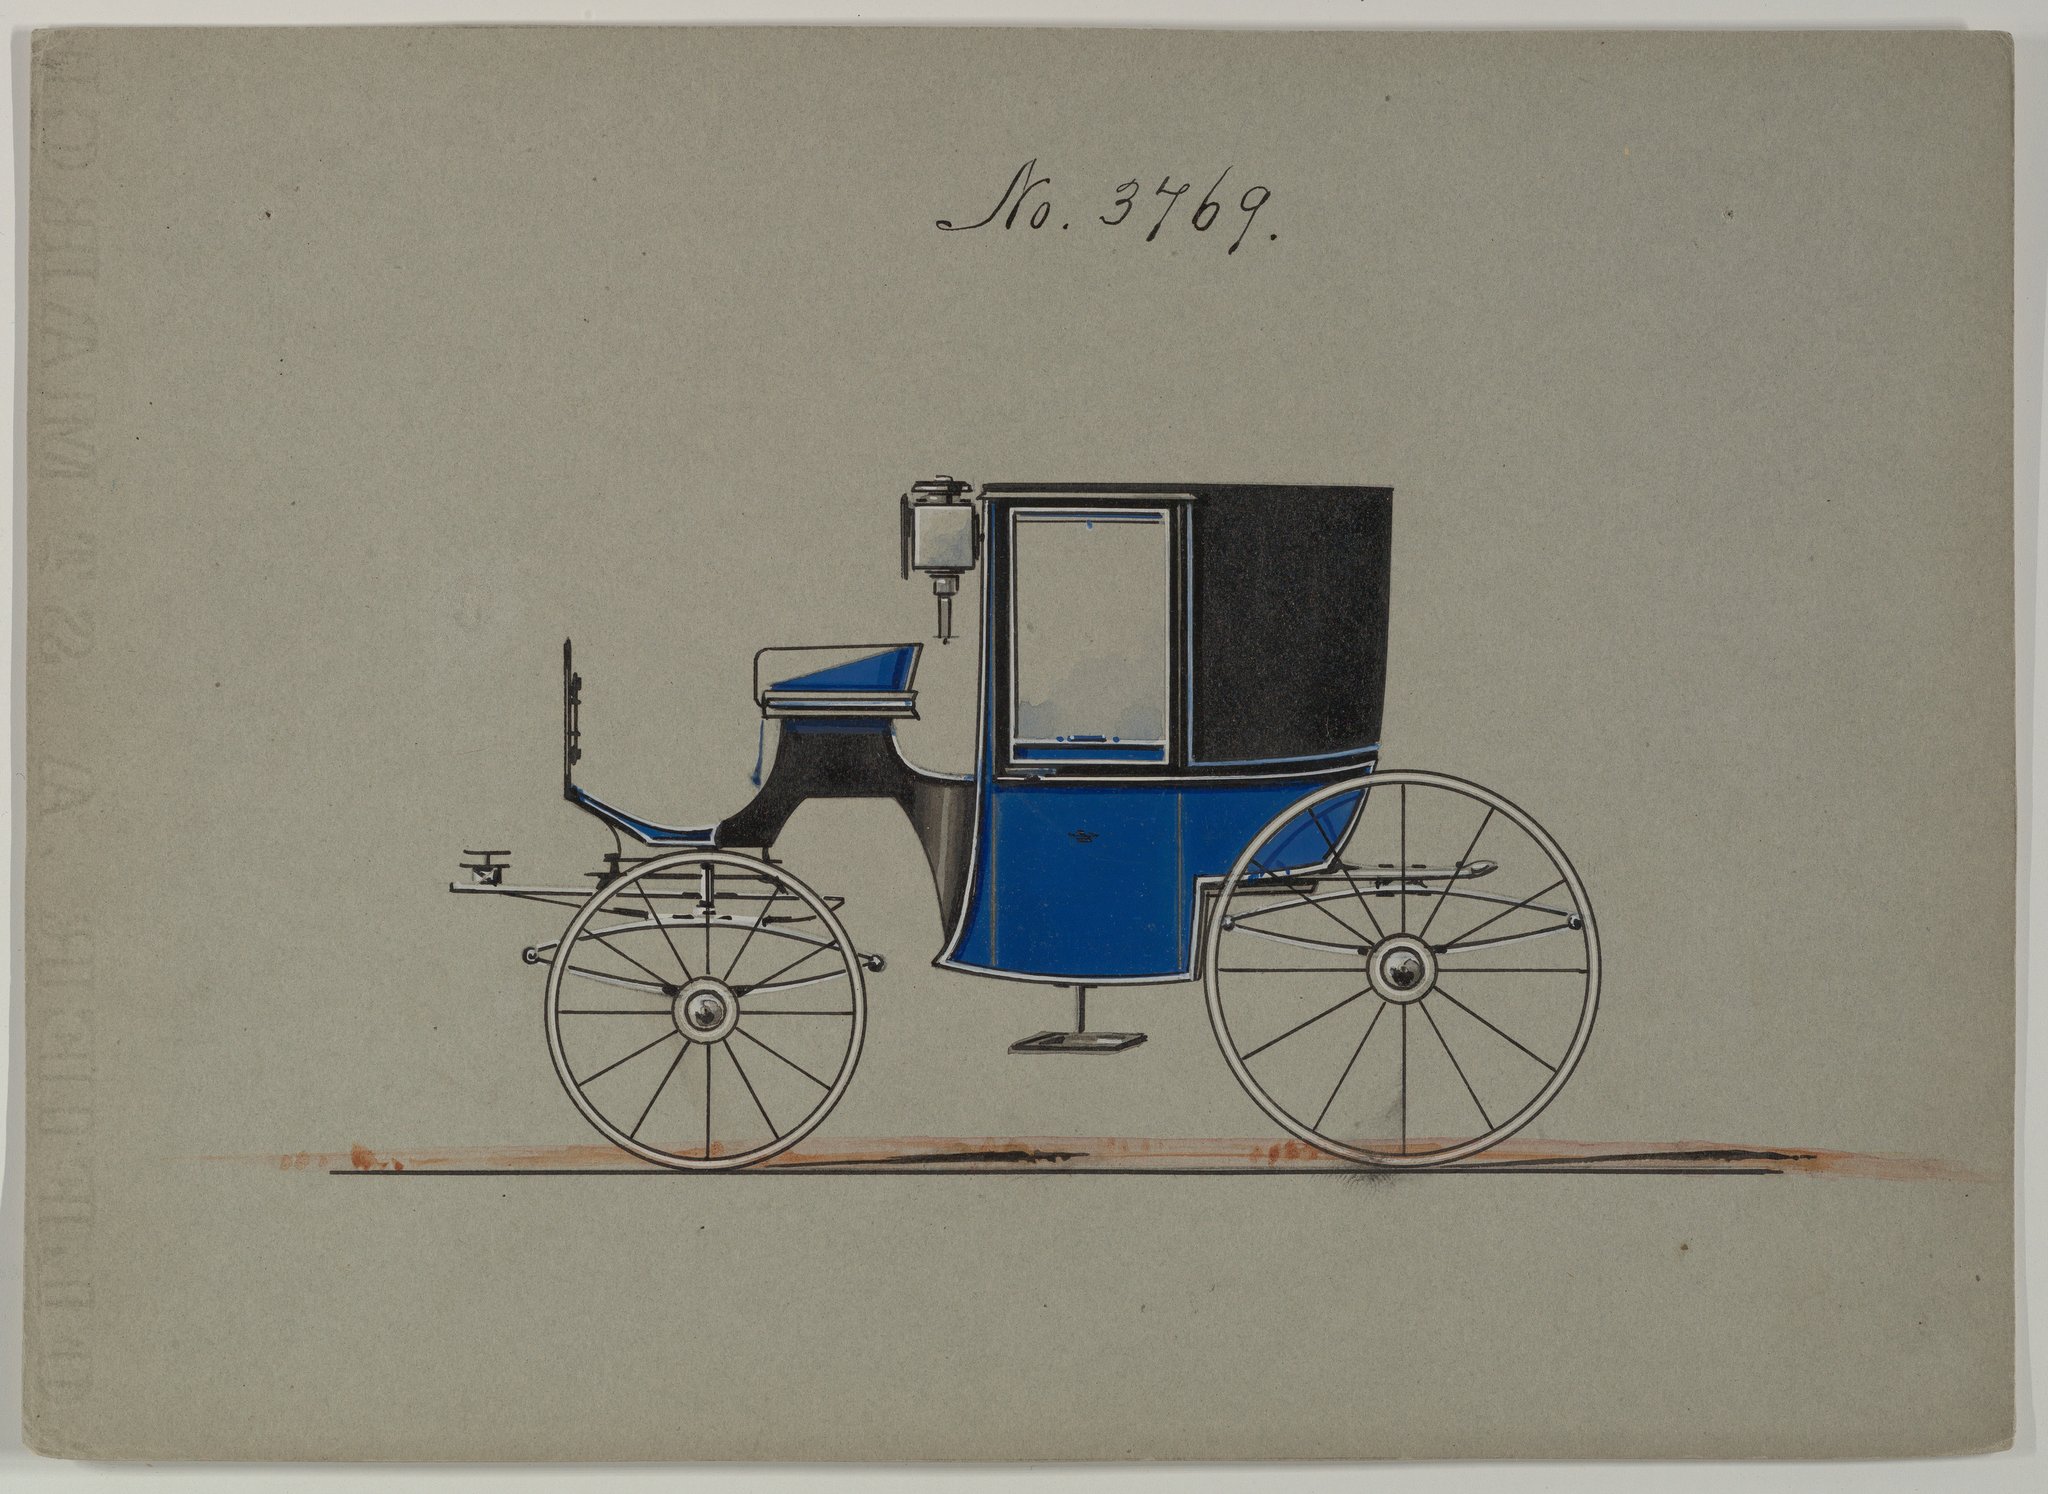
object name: drawing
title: Brougham #3769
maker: brewster & co.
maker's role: manufacturer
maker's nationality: american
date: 1882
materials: gouache, gum arabic, ink, watercolor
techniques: pen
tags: carriages